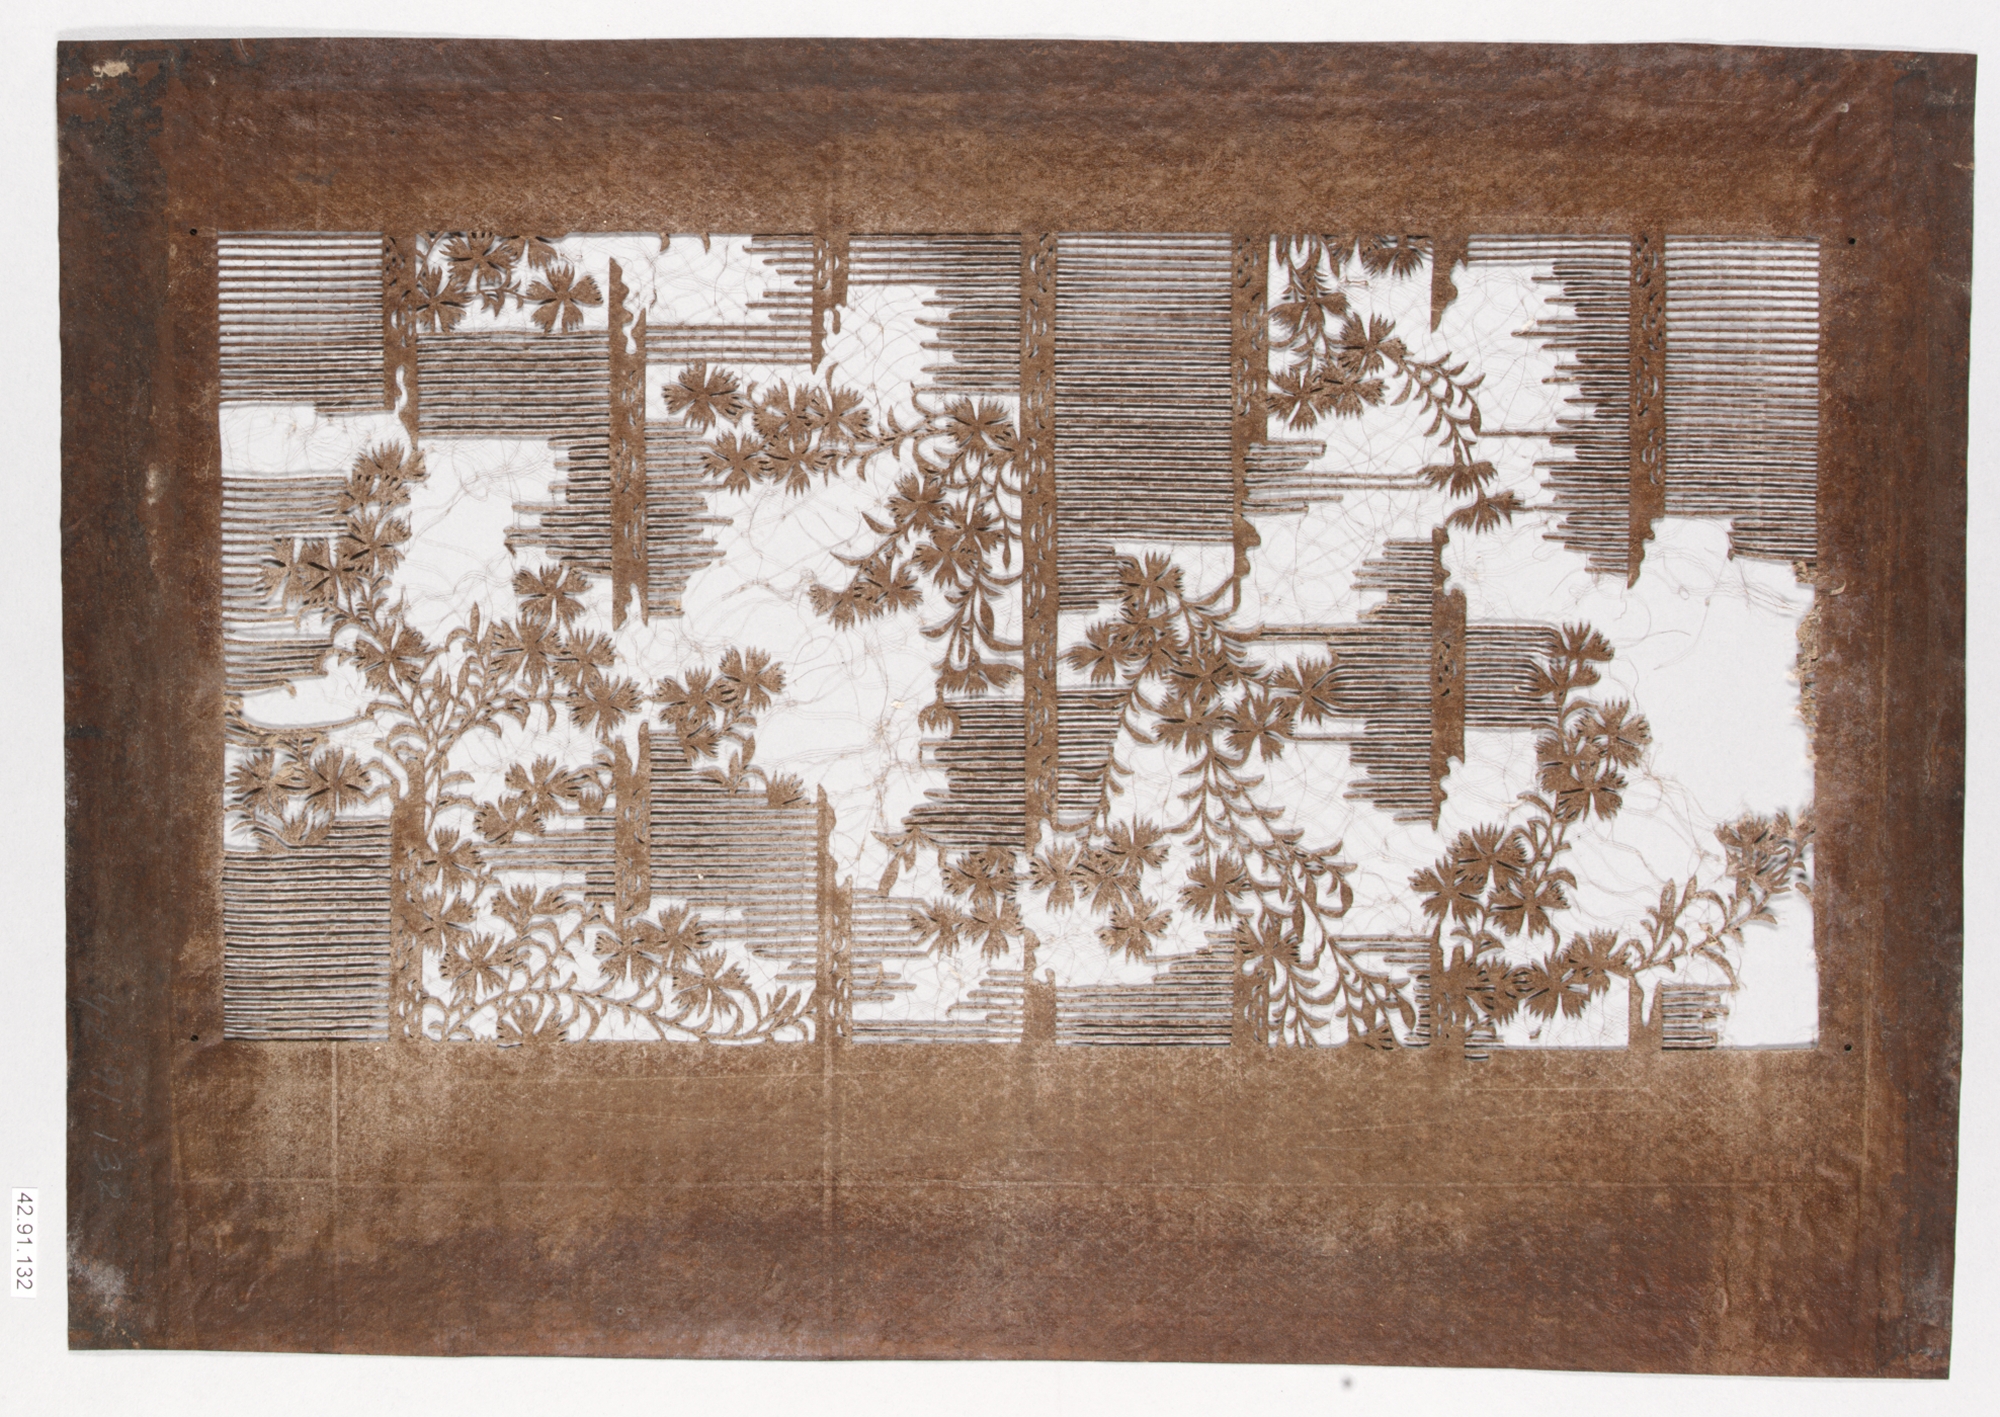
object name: stencil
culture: japanese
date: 1801-1900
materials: paper, silk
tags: flowers